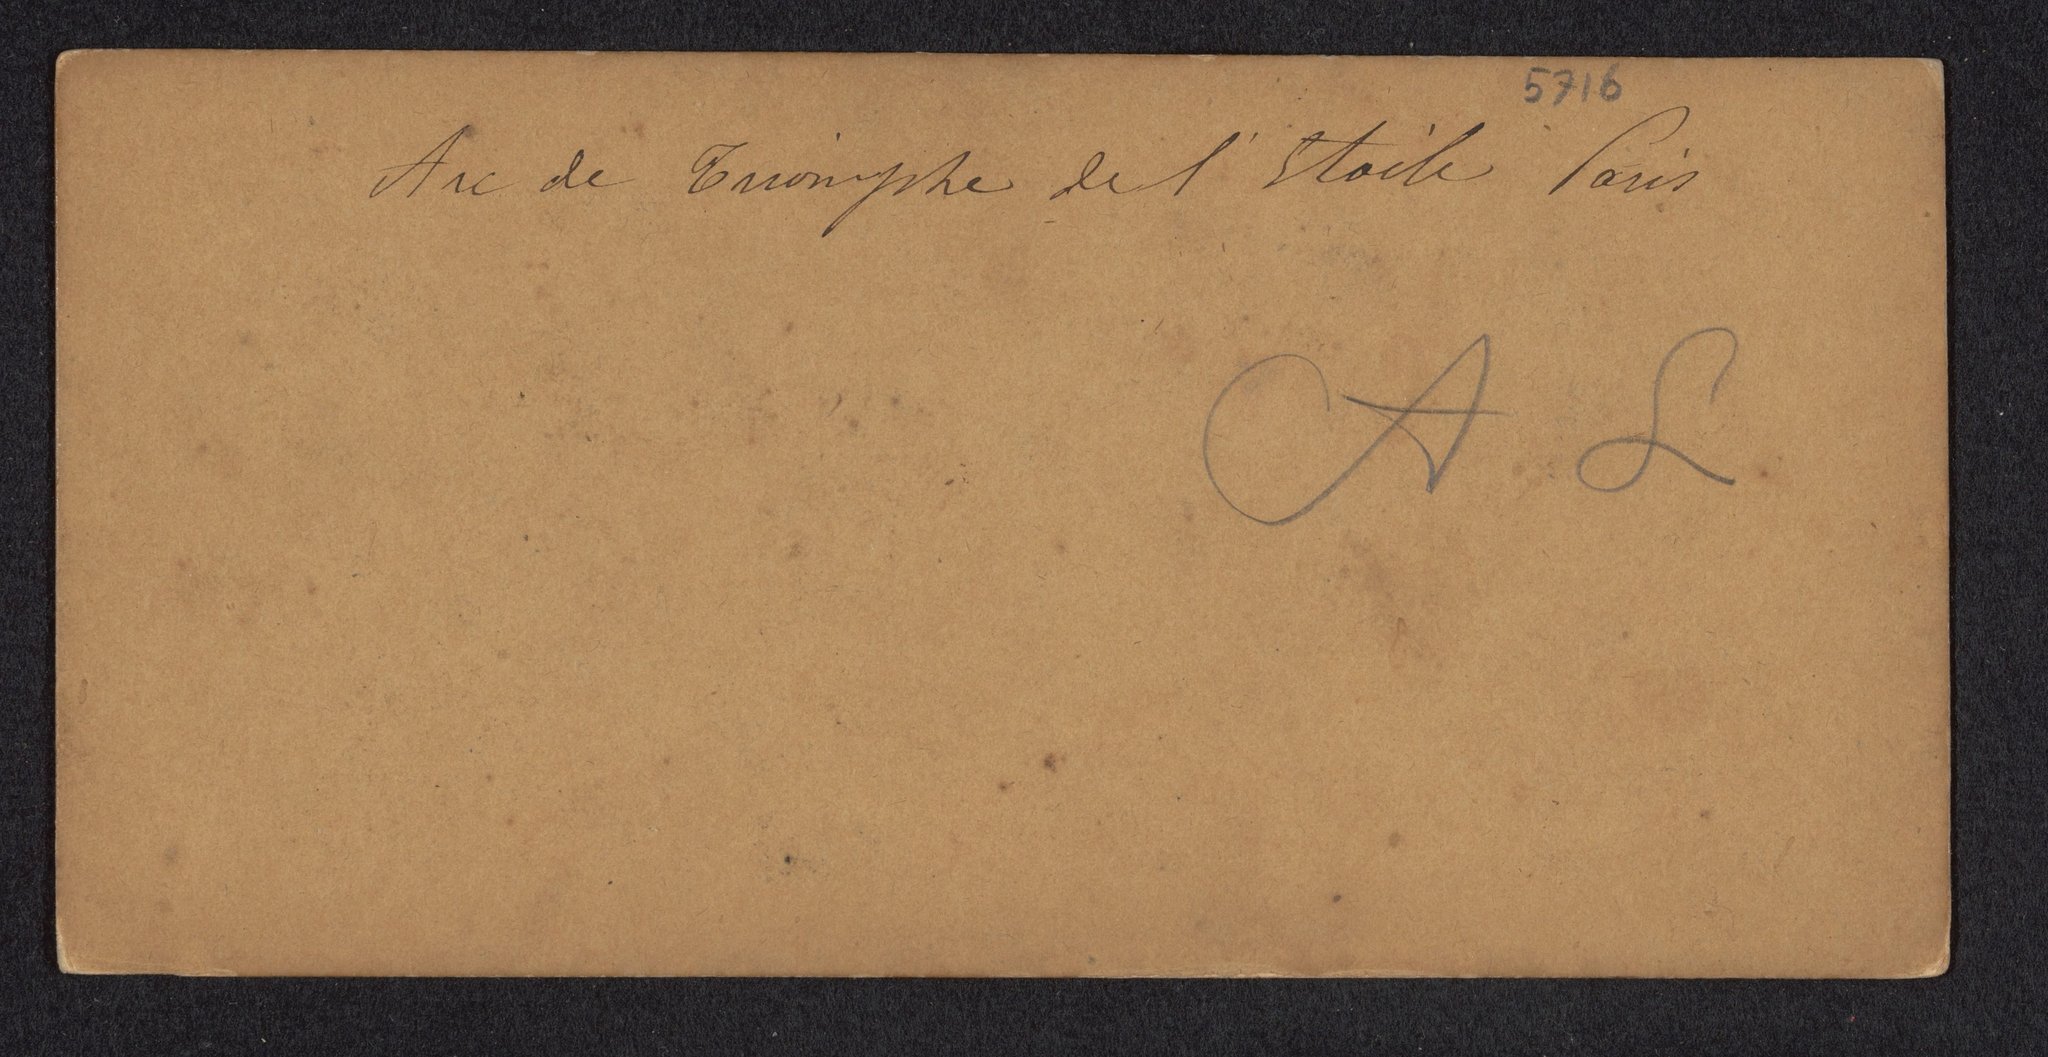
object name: stereograph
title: Gezicht op de Arc de Triomphe in Parijs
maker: Anonymous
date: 1850-1880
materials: cardboard, photographic support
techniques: albumen print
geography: paris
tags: triumphal arch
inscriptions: inscription: ‘Arc de Triomphe de l'Etoile Paris’, annotation: ‘A.L.’